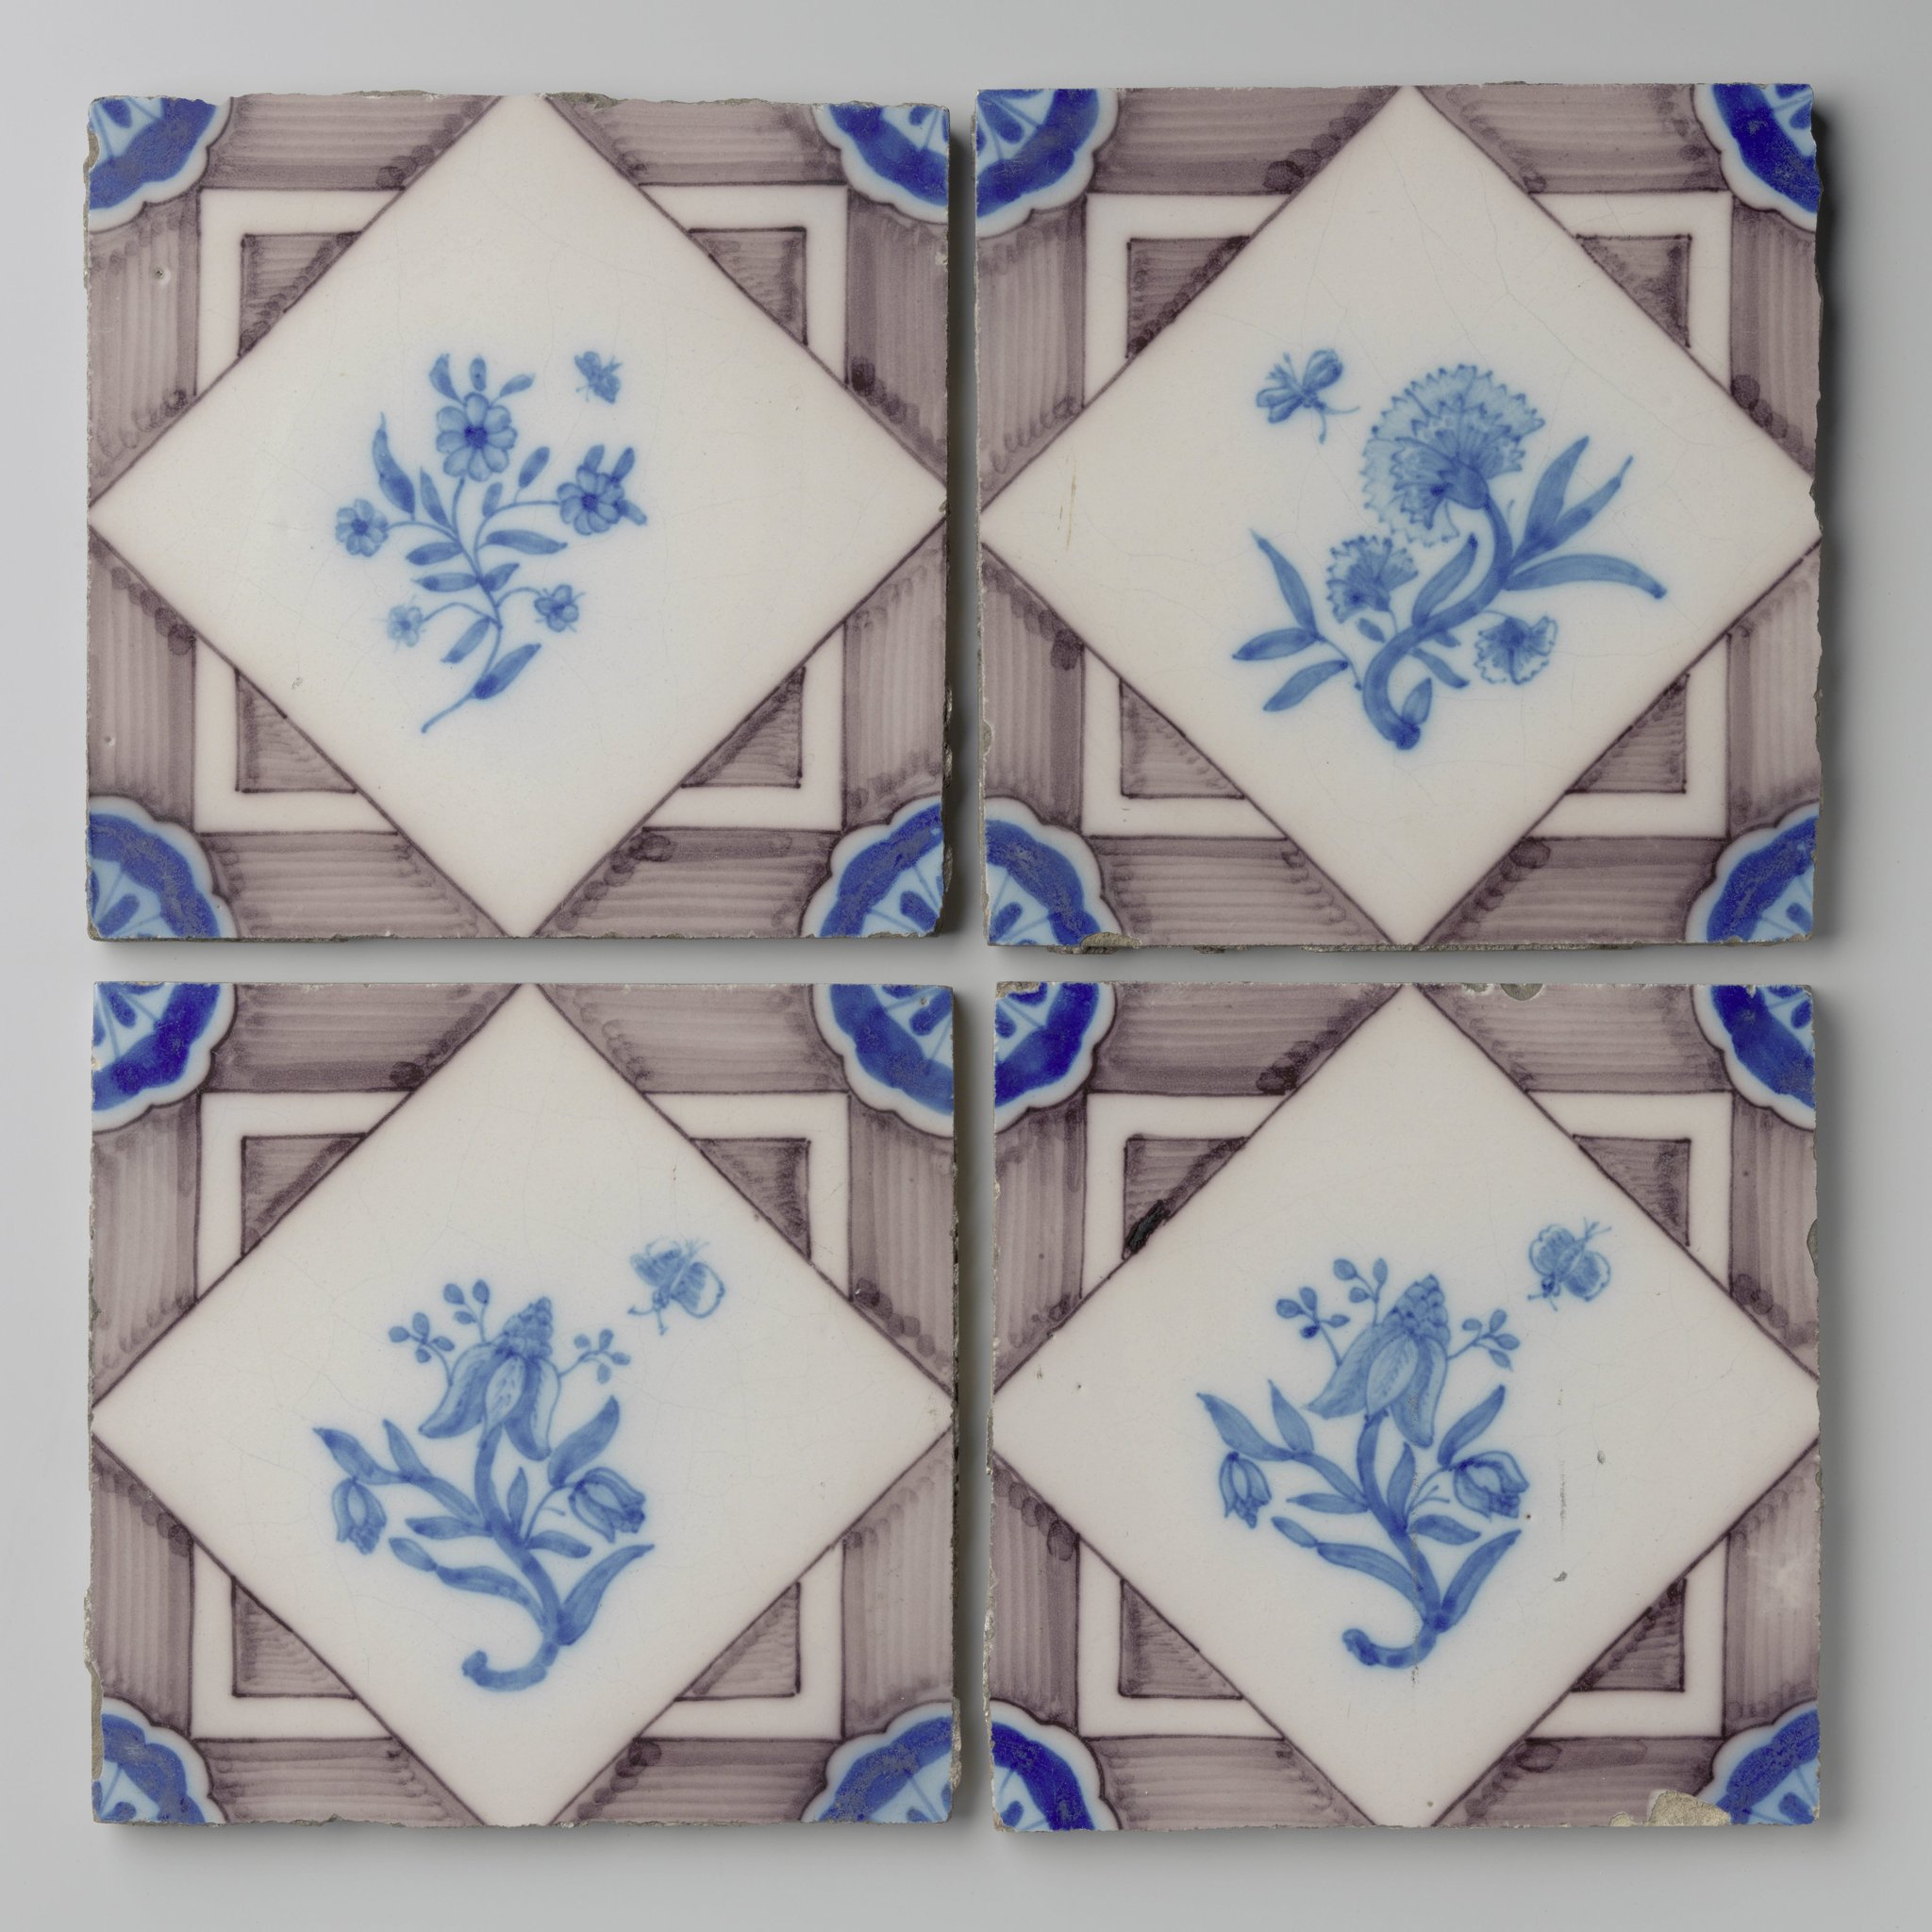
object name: tile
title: Vier vierkante tegels met bloemen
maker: Anonymous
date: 1720-1750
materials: earthenware, glaze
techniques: maiolica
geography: netherlands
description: Vier vierkante tegels met blauwe bloemen in de kwadraat op een vierkant. Het geheel op een gesprenkeld paars fond. In de hoeken een abstracte blauwe bloemvorm.